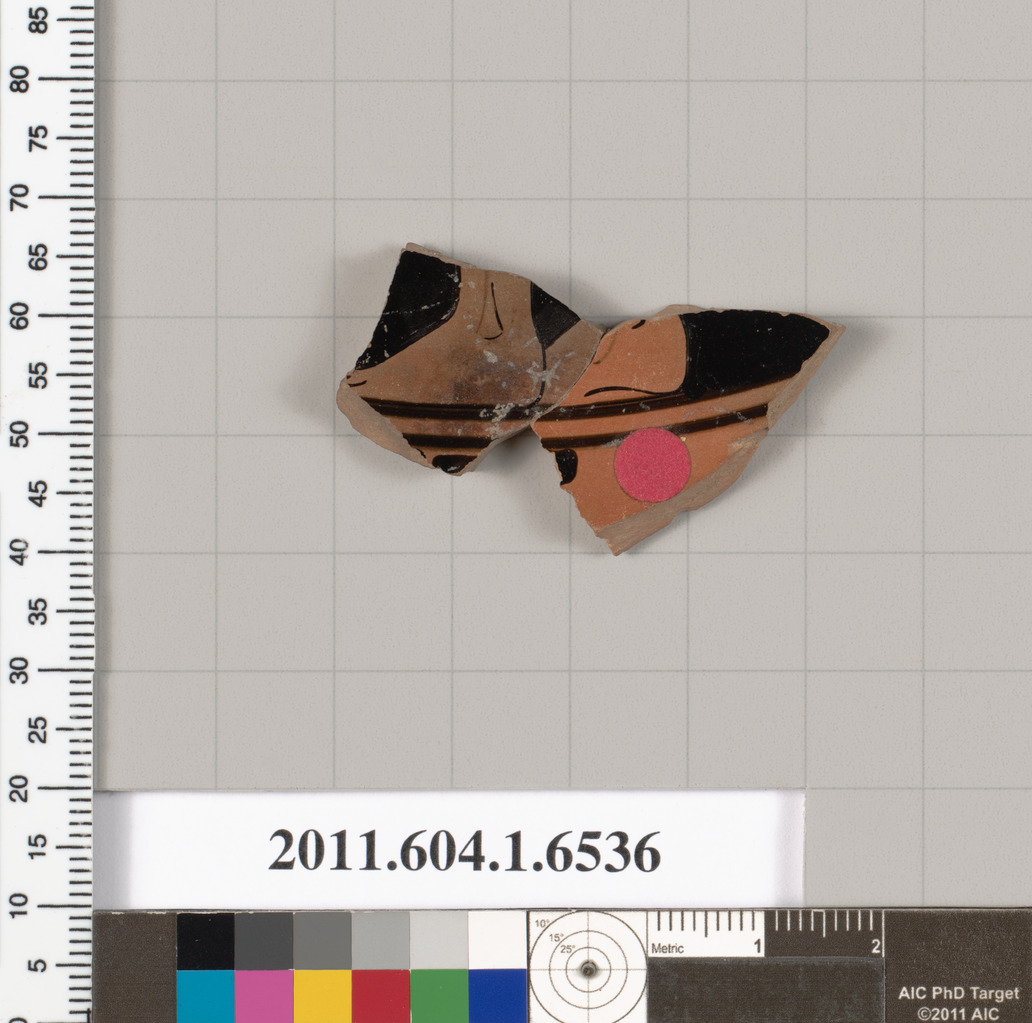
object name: kylix fragment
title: Terracotta fragment of a kylix (drinking cup)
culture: greek, attic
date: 490-480 BCE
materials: terracotta